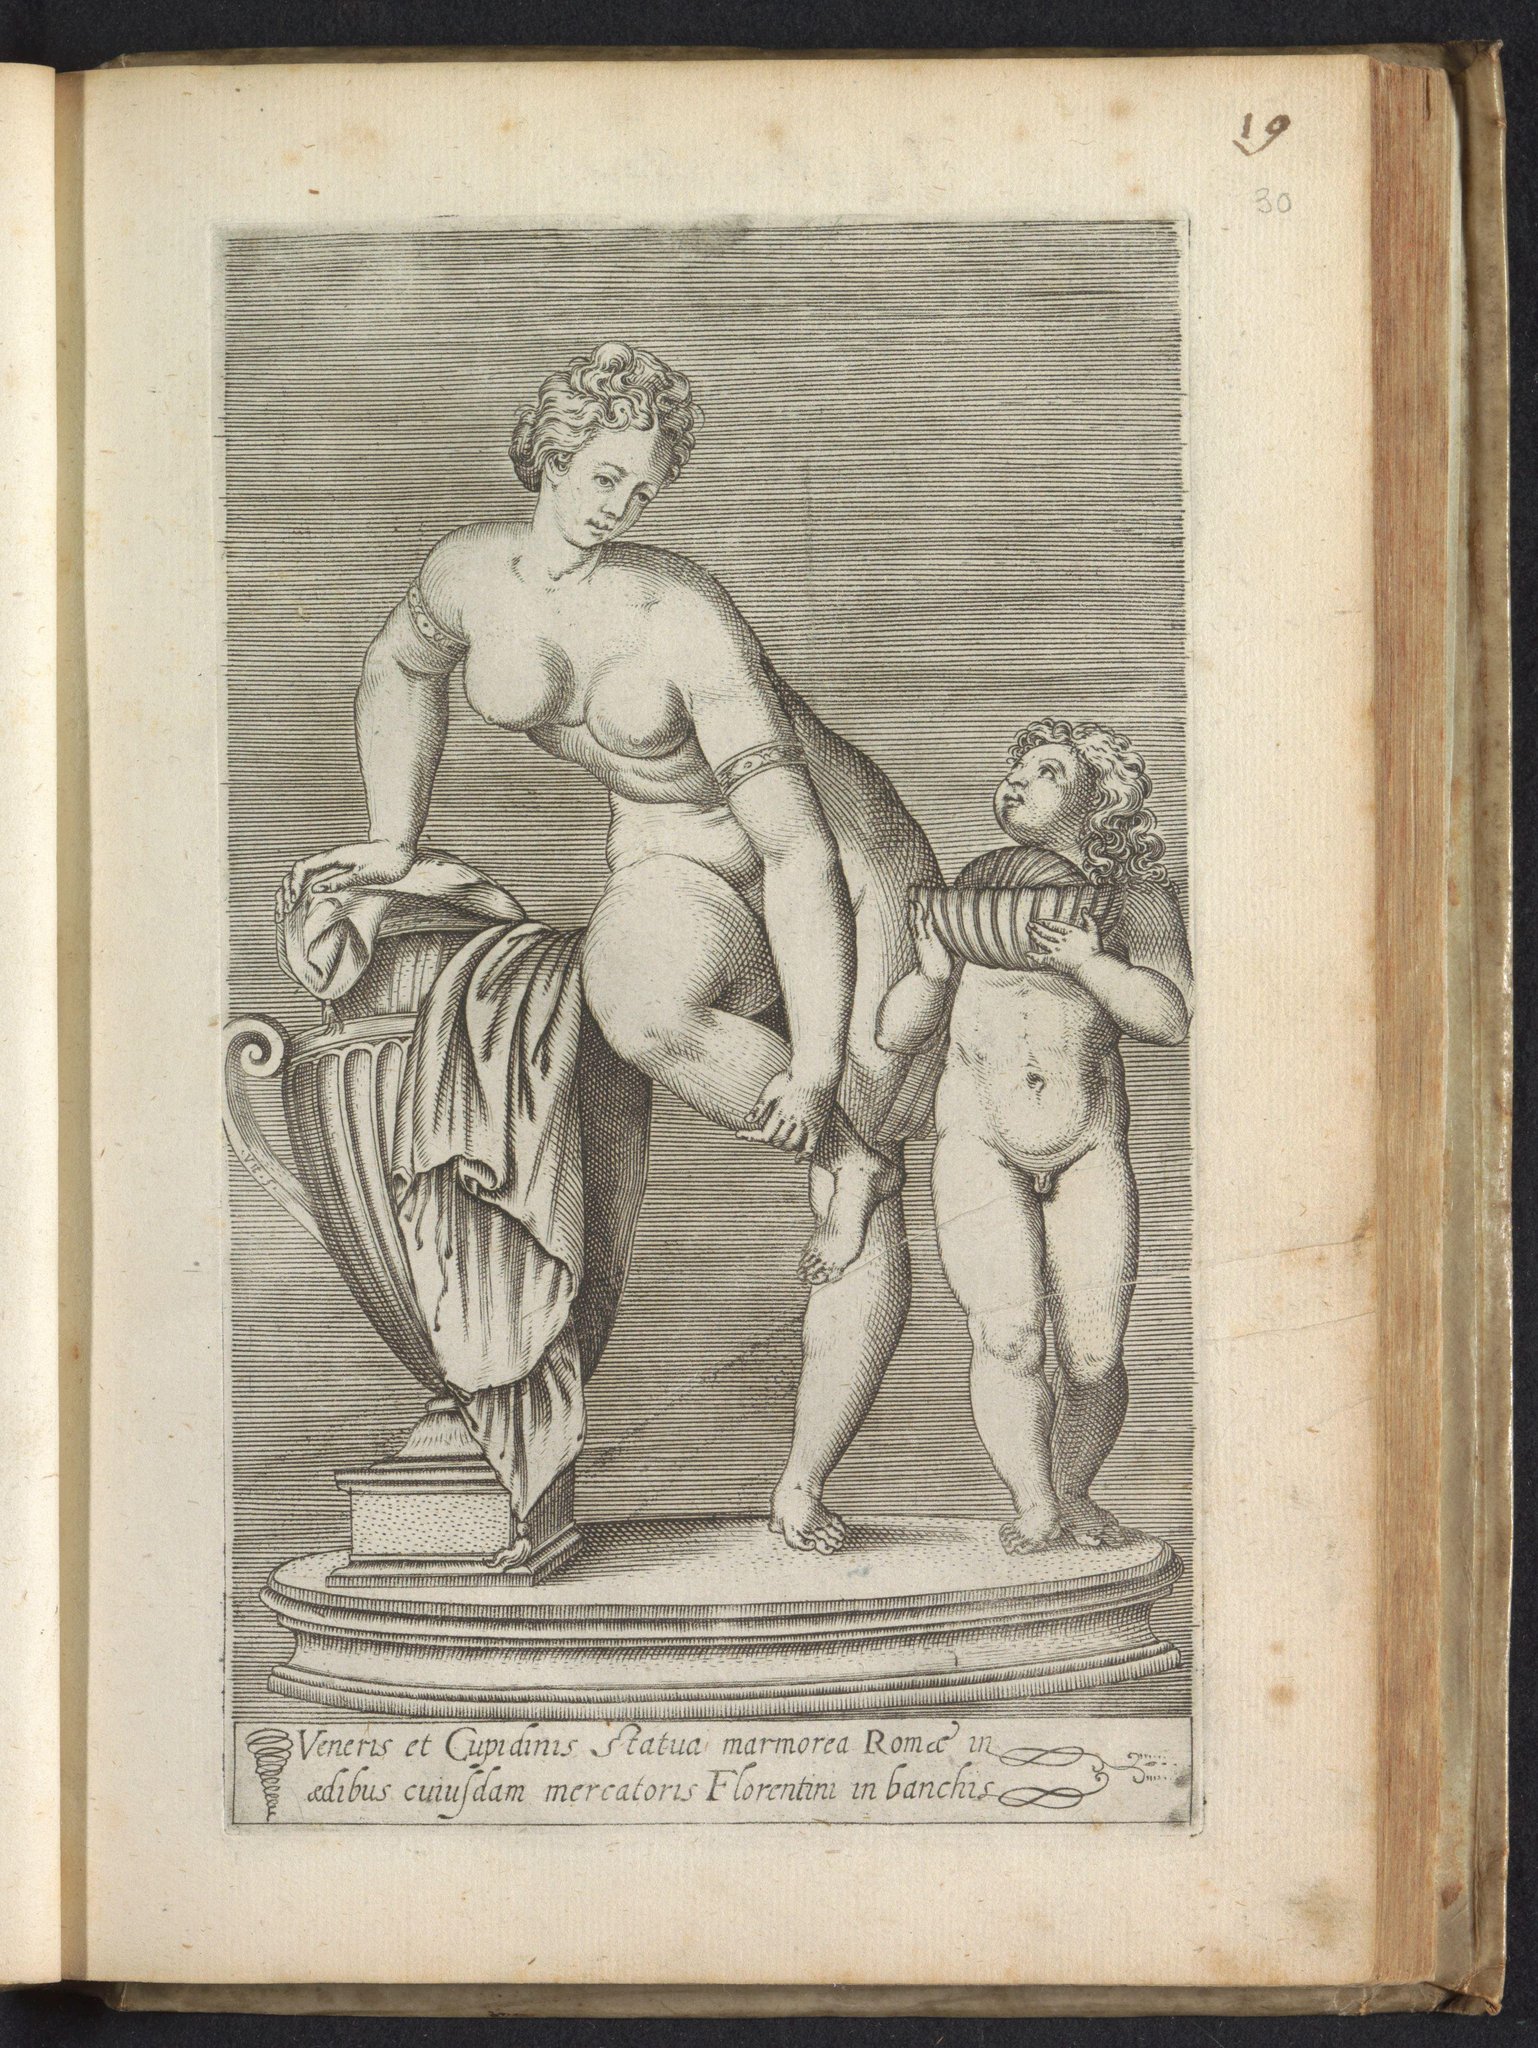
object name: print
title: Sculptuur van Venus en Amor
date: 1584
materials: paper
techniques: engraving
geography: italy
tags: bath of venus, toilet of venus, piece of sculpture, reproduction of a piece of sculpture, venus and cupid (cupid not being mere attribute)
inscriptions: number: ‘19’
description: Deze prent maakt deel uit van een set van 79 prenten (+ titelprent) met voorstellingen van antieke sculpturen in Rome.